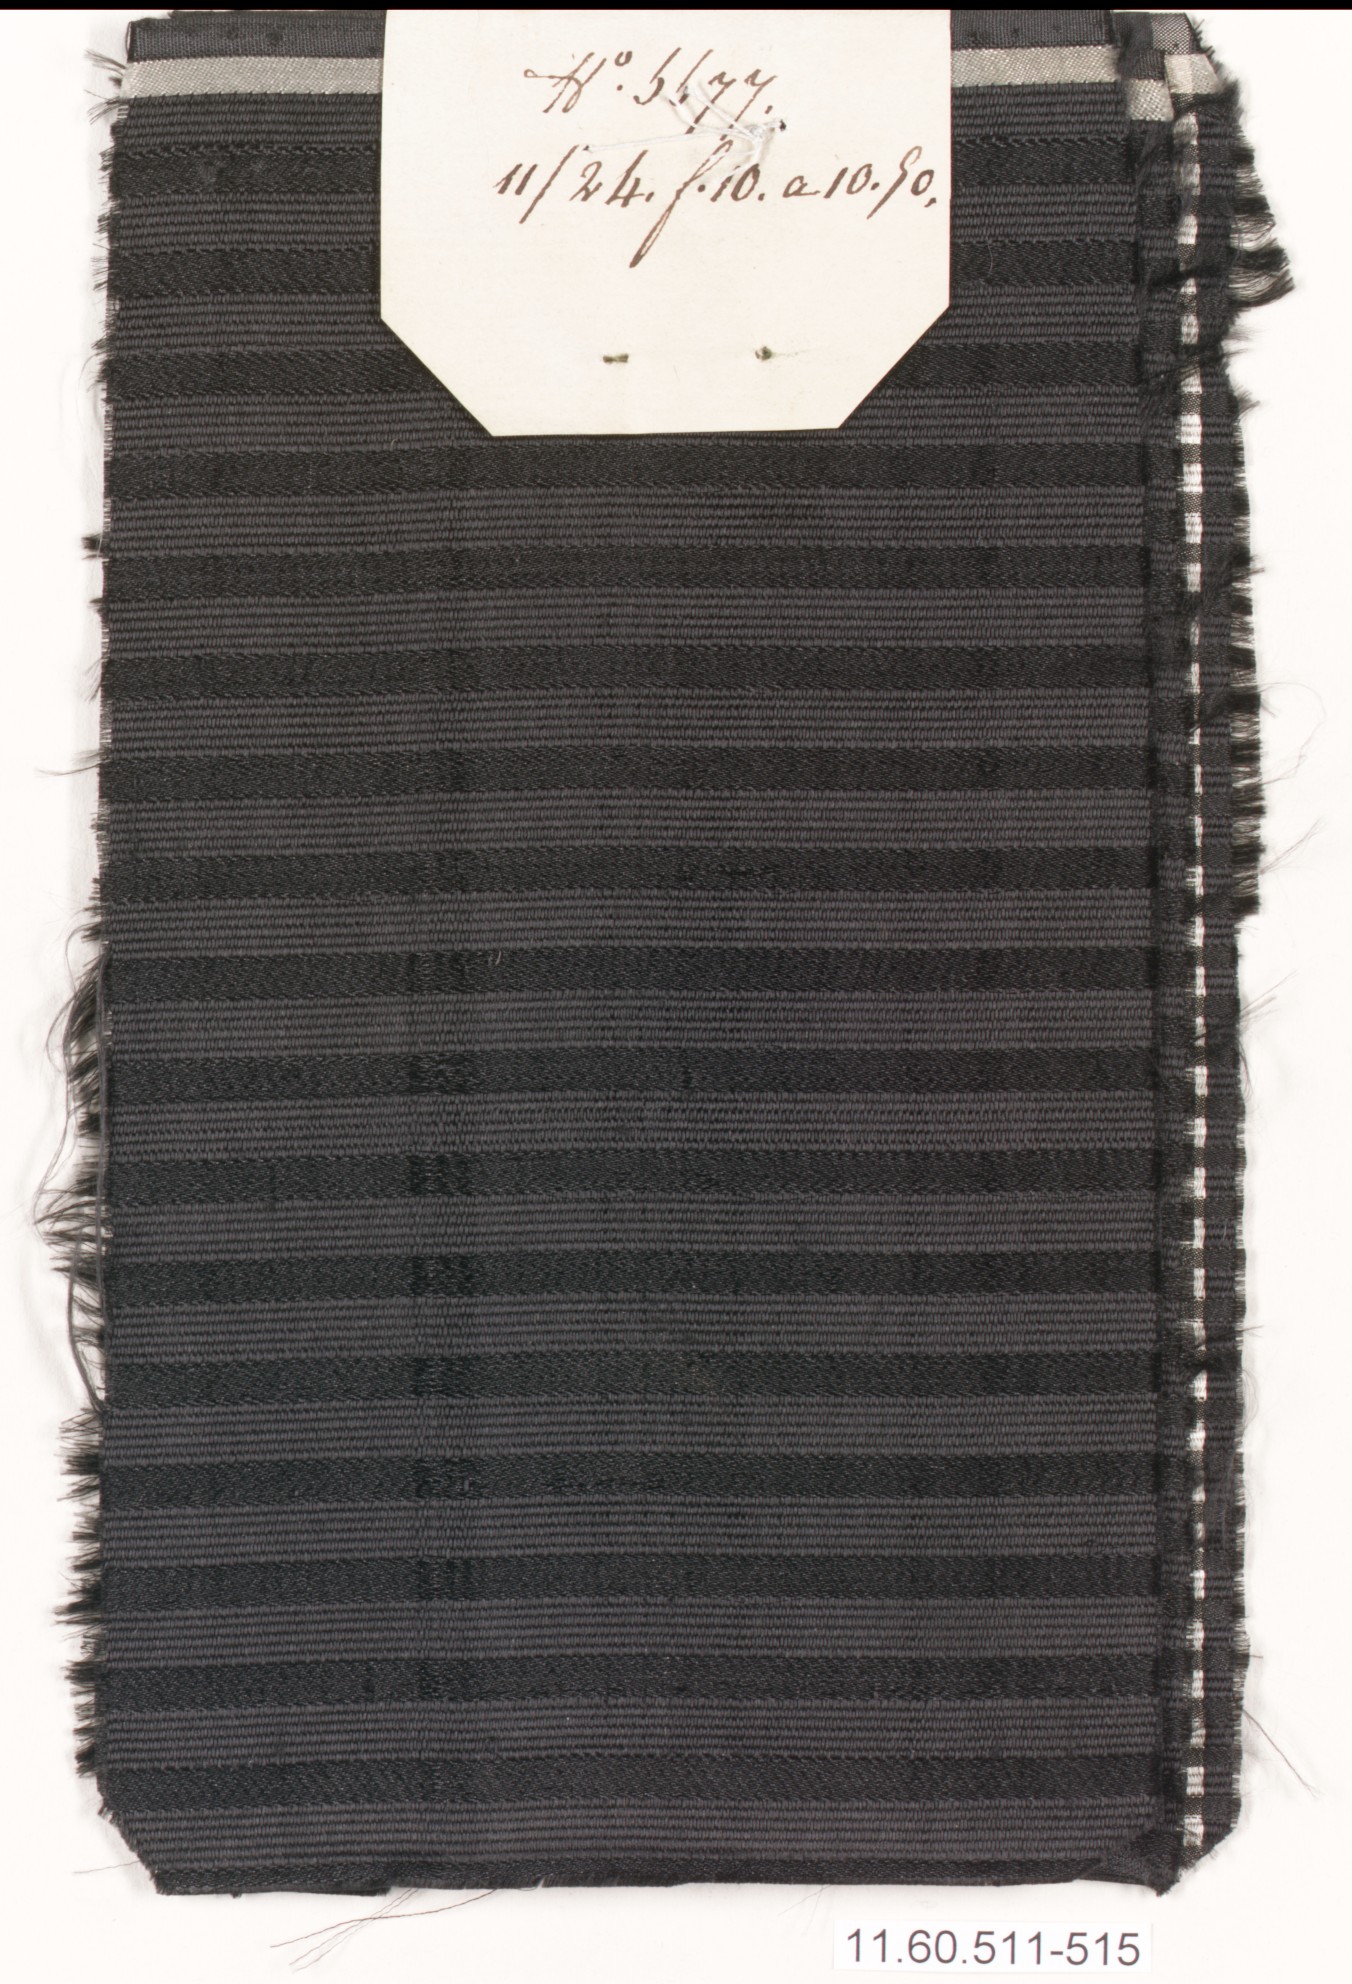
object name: sample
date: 1825-1850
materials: silk